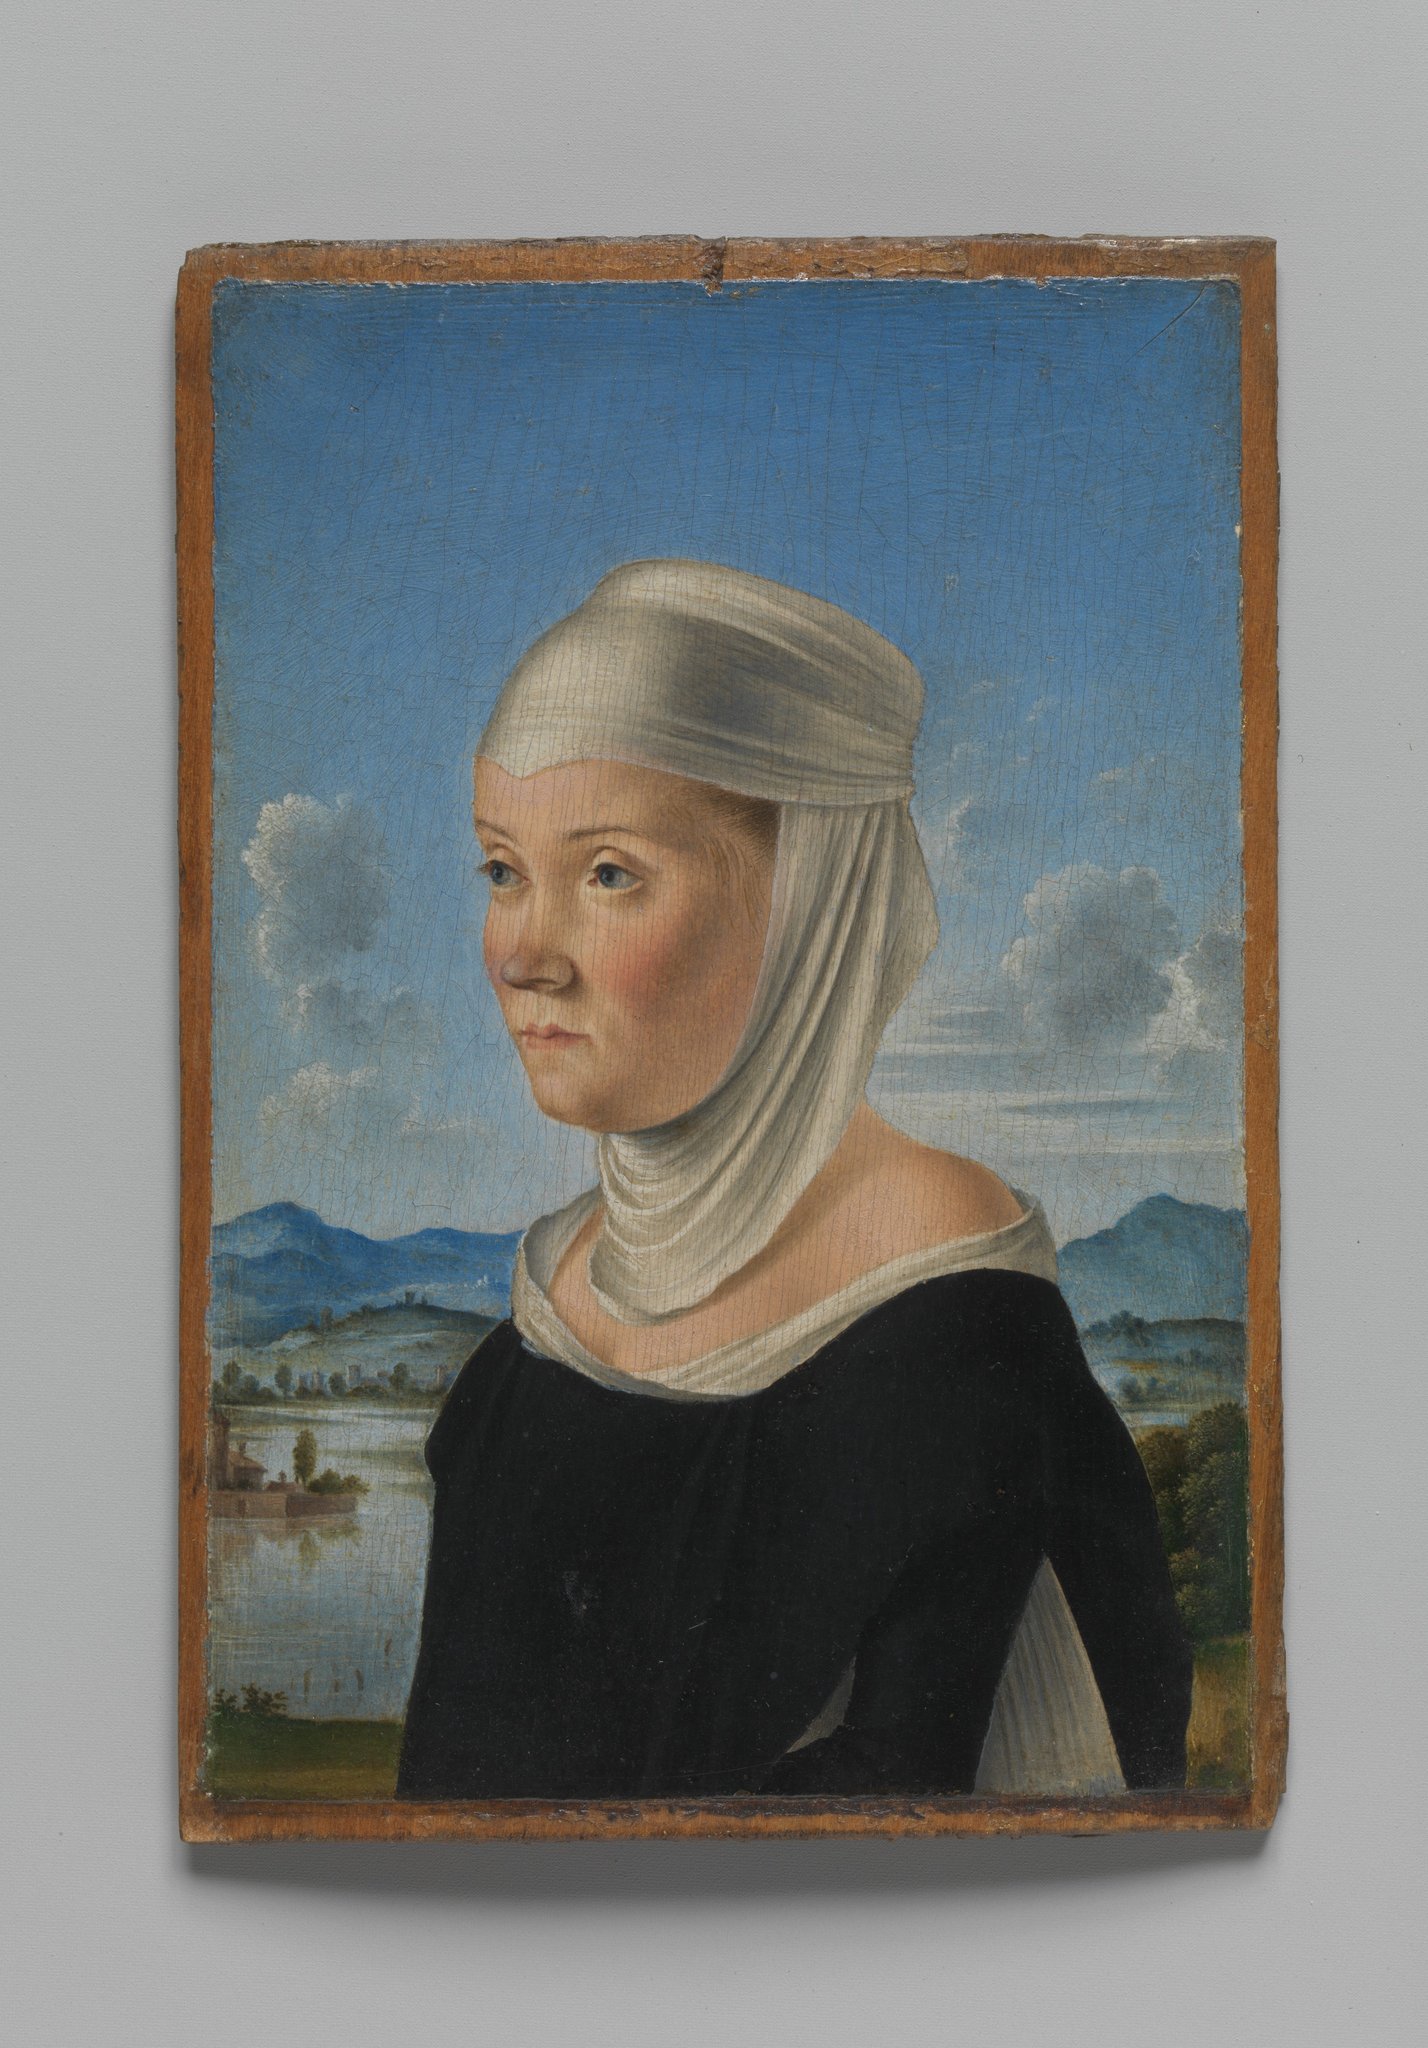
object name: painting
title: Portrait of a Woman, Possibly a Nun of San Secondo; (verso) Scene in Grisaille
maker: jacometto (jacometto veneziano)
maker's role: artist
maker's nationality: italian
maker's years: 1472-1498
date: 1485-1495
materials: oil, wood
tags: portraits,women